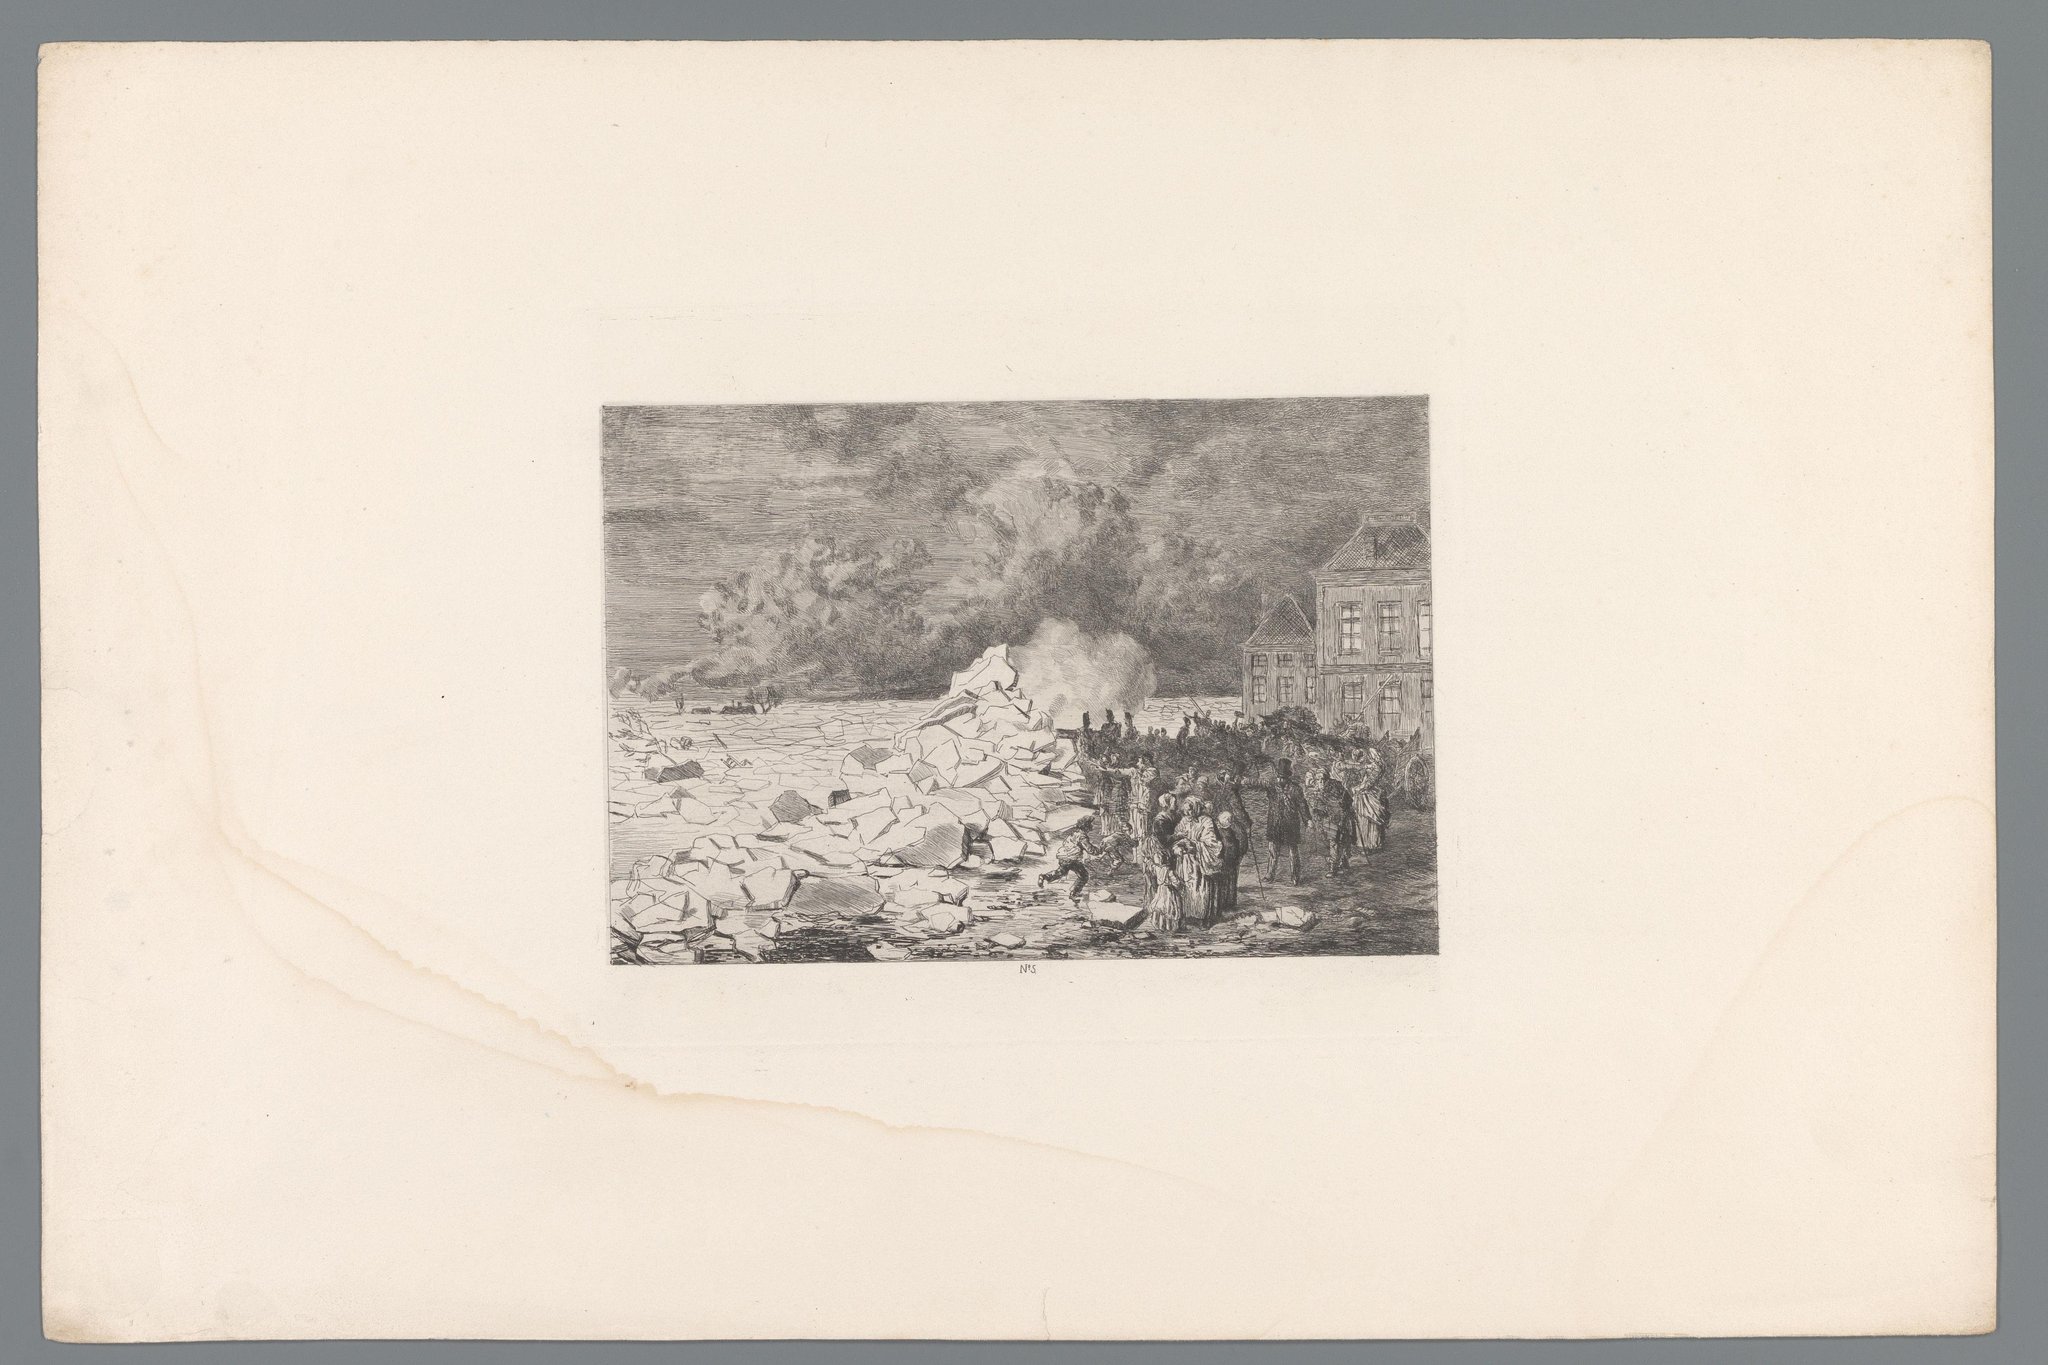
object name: print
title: De Waterramp van 1855. Geschetst in 24 afbeeldingen, naar de natuur geteekend en geëtst door leden der Maatschappij Arti et Amicitiae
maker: reinier craeyvanger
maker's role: draughtsman, print maker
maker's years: 1812-1880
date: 1855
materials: paper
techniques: drypoint, etching, intaglio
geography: netherlands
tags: flood, drift ice, arnhem